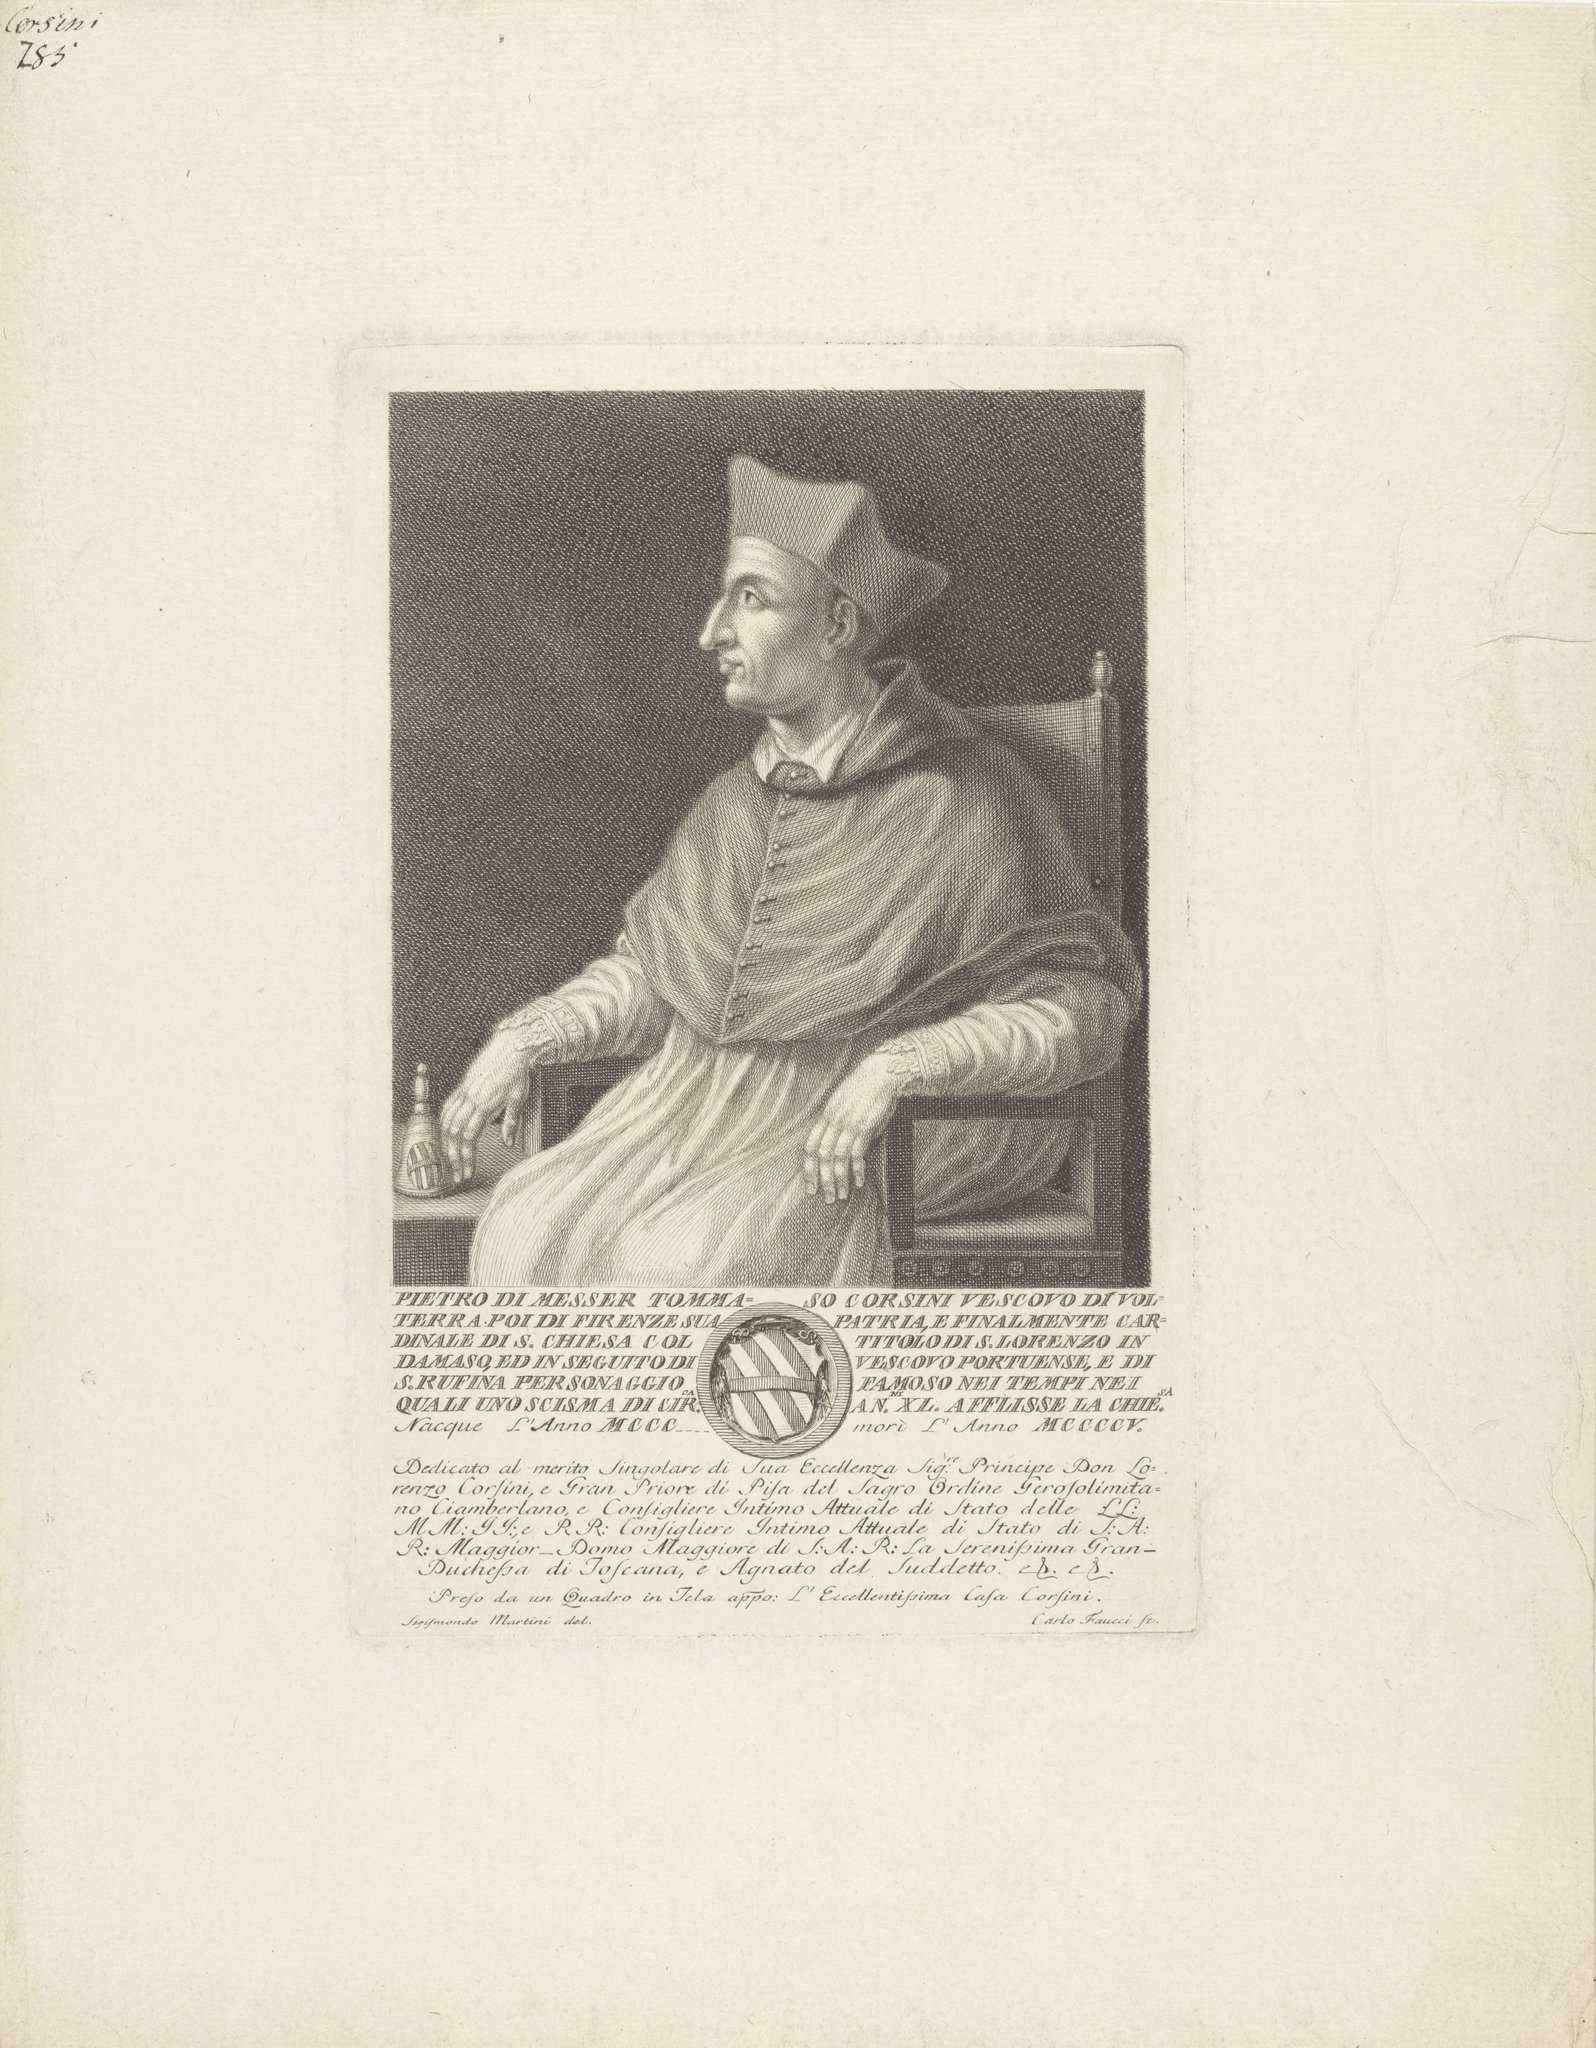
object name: print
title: Portret van kardinaal Pietro Corsini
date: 1739-1784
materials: paper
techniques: etching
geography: italy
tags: cardinal, historical persons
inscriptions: inscription: ‘Corsini / 285’, collector's mark: Lugt 2228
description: Deze prent maakt deel uit van een reeks portretprenten van onbekende omvang. De prenten zijn gemaakt door meedere prentmakers, onder wie Francesco Allegrini en Carlo en Raimondo Faucci.